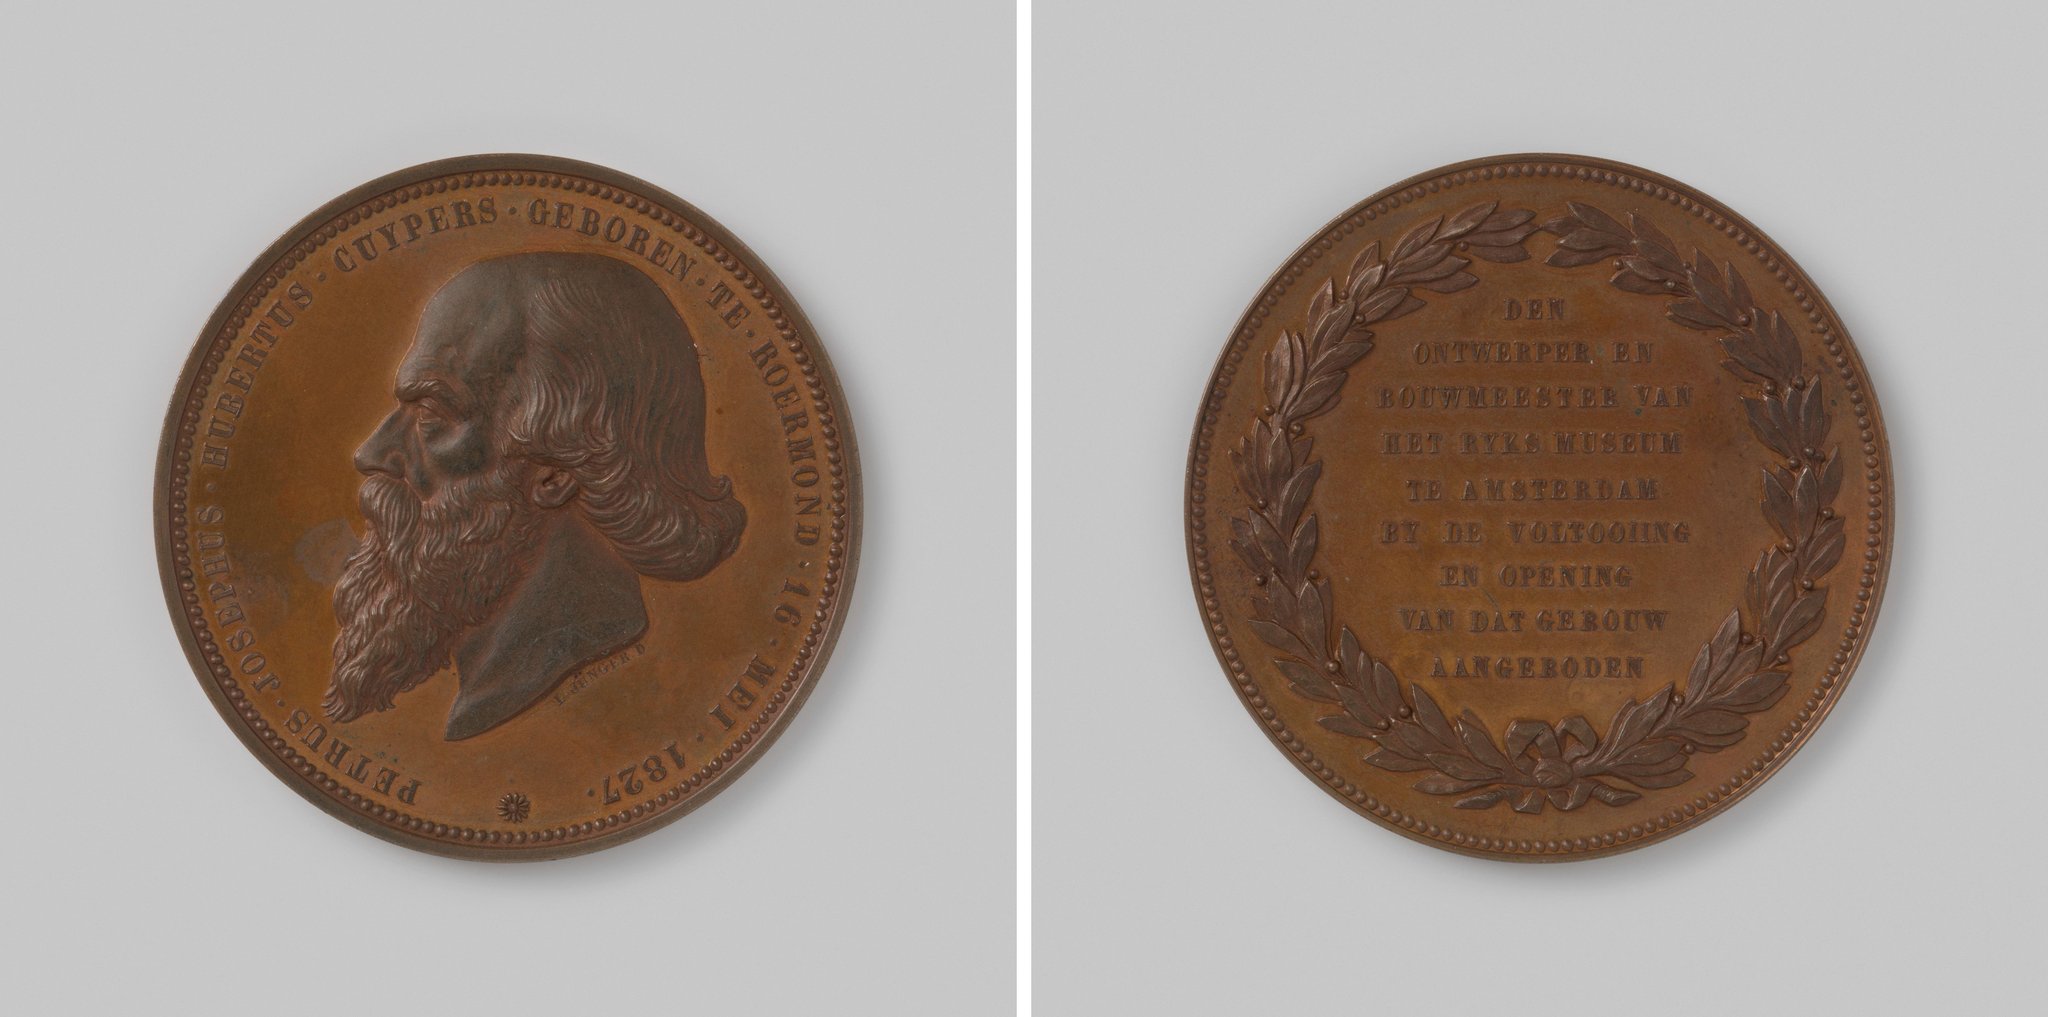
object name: honorary medal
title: P.J.H. Cuypers, penning aangeboden bij de opening van het Rijksmuseum te Amsterdam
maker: ludwig jünger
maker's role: medailleur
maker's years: 1857-1908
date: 1885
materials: bronze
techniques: striking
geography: utrecht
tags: draughtsman, pierre joseph hubert cuypers, rijksmuseum amsterdam, amsterdam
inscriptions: signature: ‘L. JÜNGER . D .’, inscription: ‘J.P.M.F.’, circumscription: ‘PETRUS . JOSEPHUS . HUBERTUS . CUYPERS . GEBOREN . TE . ROERMOND . 16 . MEI . 1827’, inscription: ‘DEN / ONTWERPER EN / BOUWMEESTER VAN / HET RYKS MUSEUM / TE AMSTERDAM / BY DE VOLTOOIING / EN OPENING / VAN DAT GEBOUW / AANGEBODEN’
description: Bronzen penning. Voorzijde: naar links gekeerd profiel van Cuypers in reliëf binnen omschrift. Keerzijde: opschrift binnen lauwerkrans.